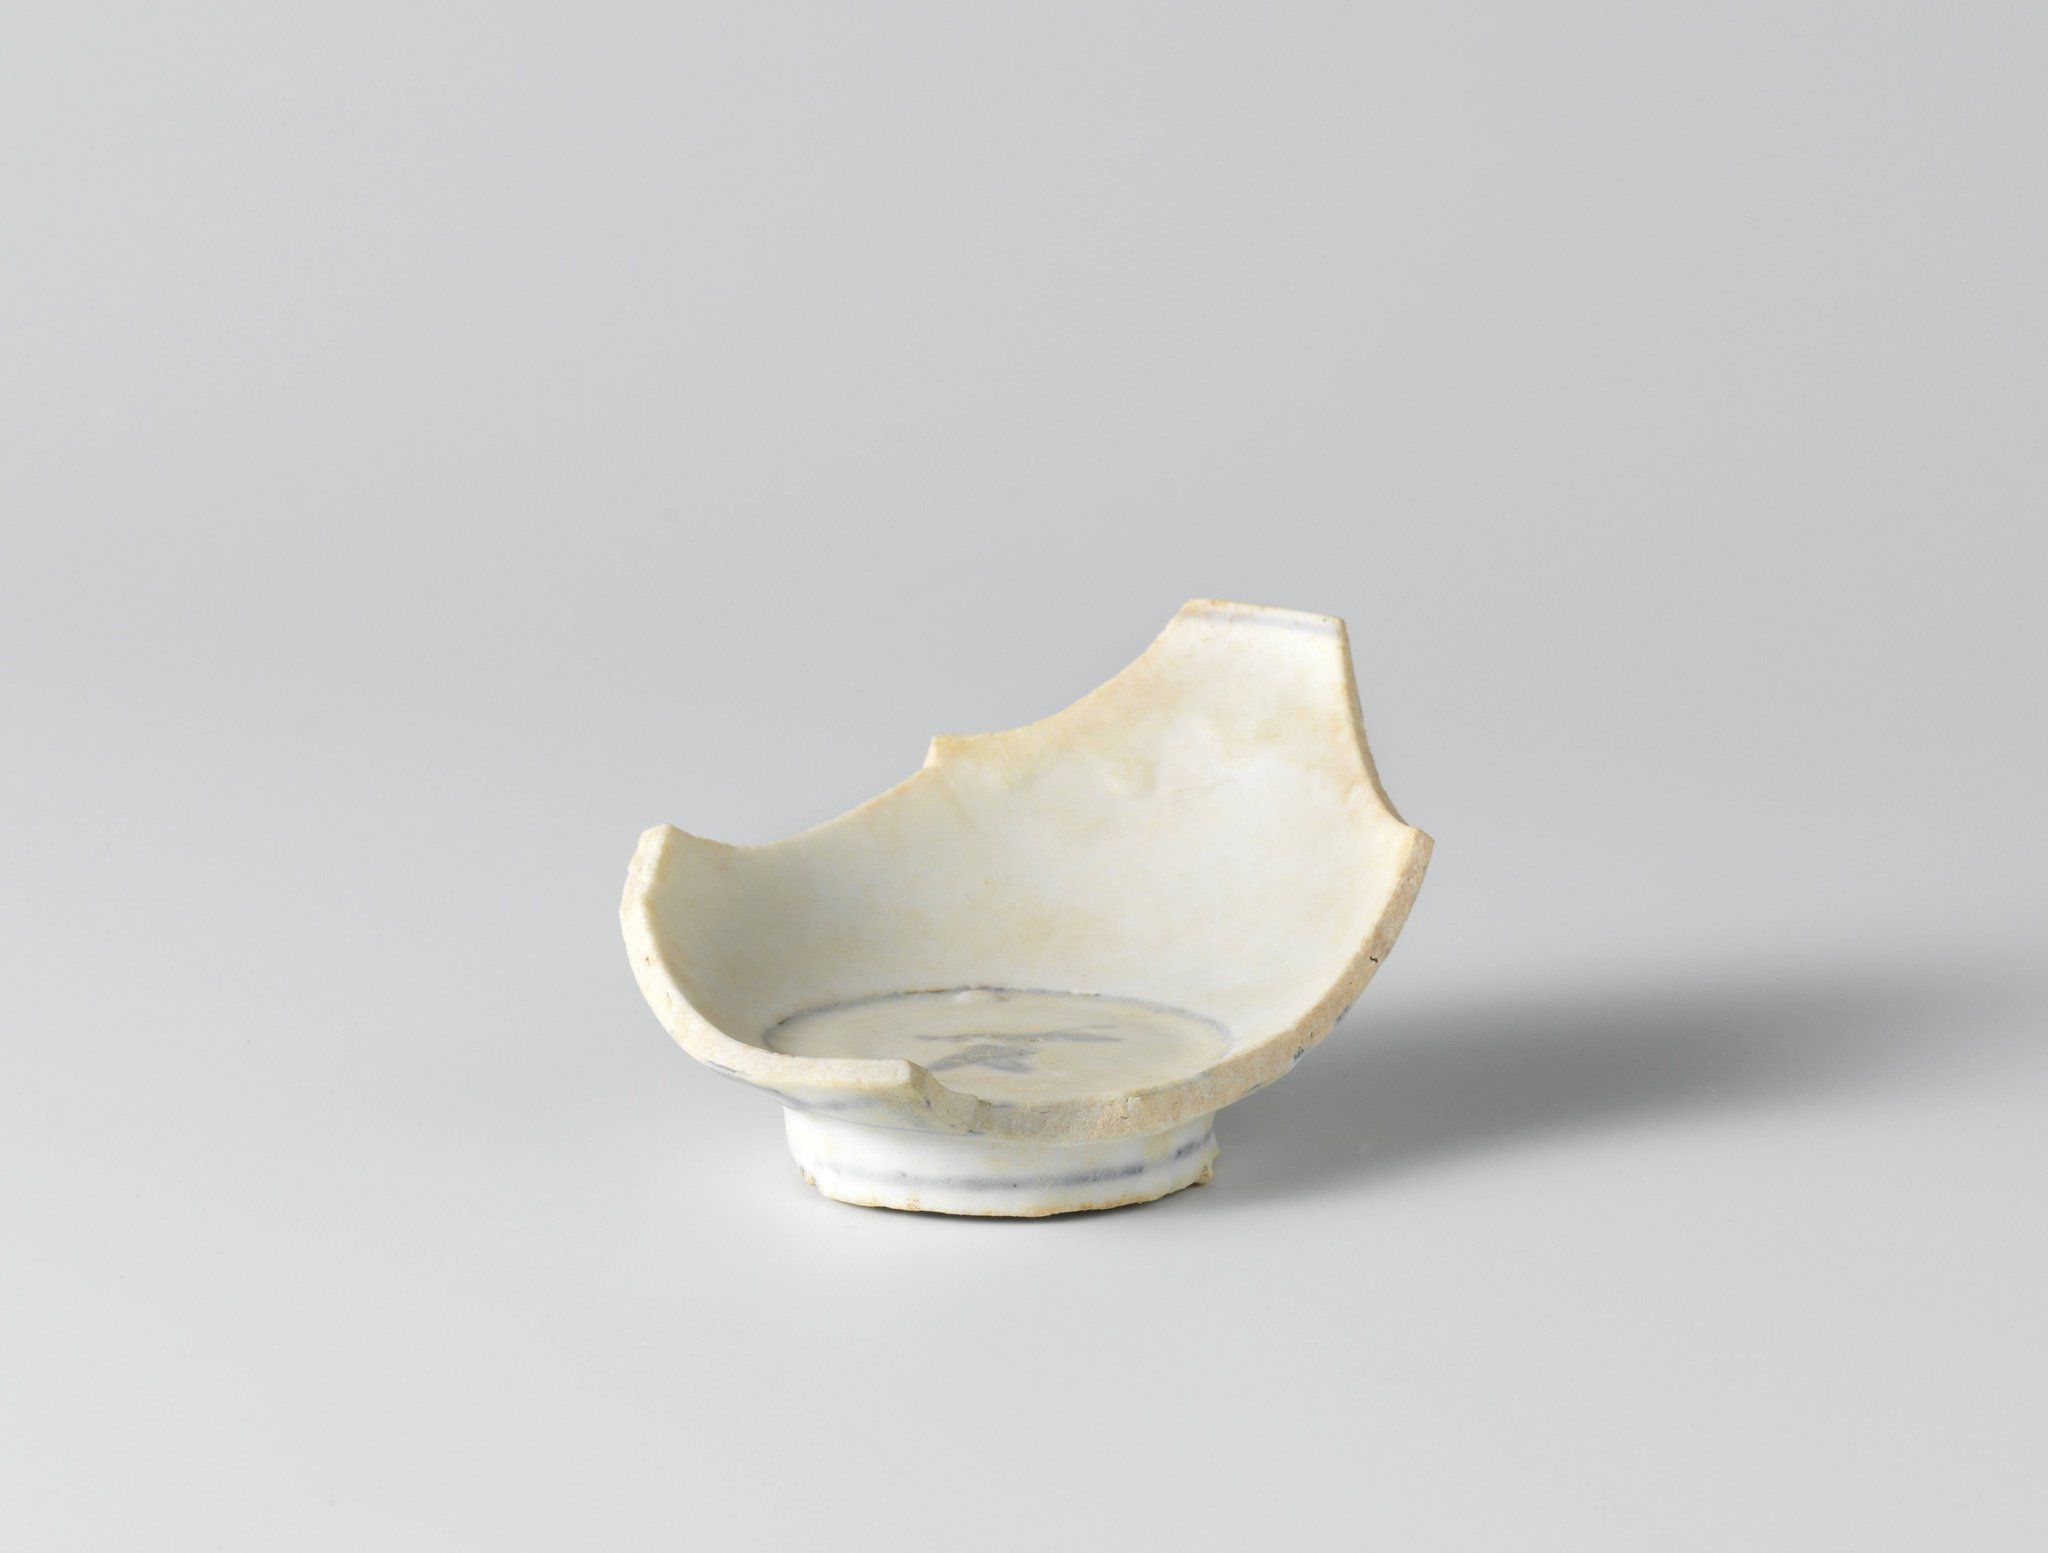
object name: bowl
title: Fragment kom uit V.O.C.-schip de 'Witte Leeuw'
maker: Anonymous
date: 1613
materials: porcelain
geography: jingdezhen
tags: verenigde oostindische compagnie, sint-helena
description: A bowl. In the centre a simple flower is drawn encircled by a band. On the lip-rim a band is also drawn. On the outside a continuous scroll of stylized flowers is drawn very sketchily.